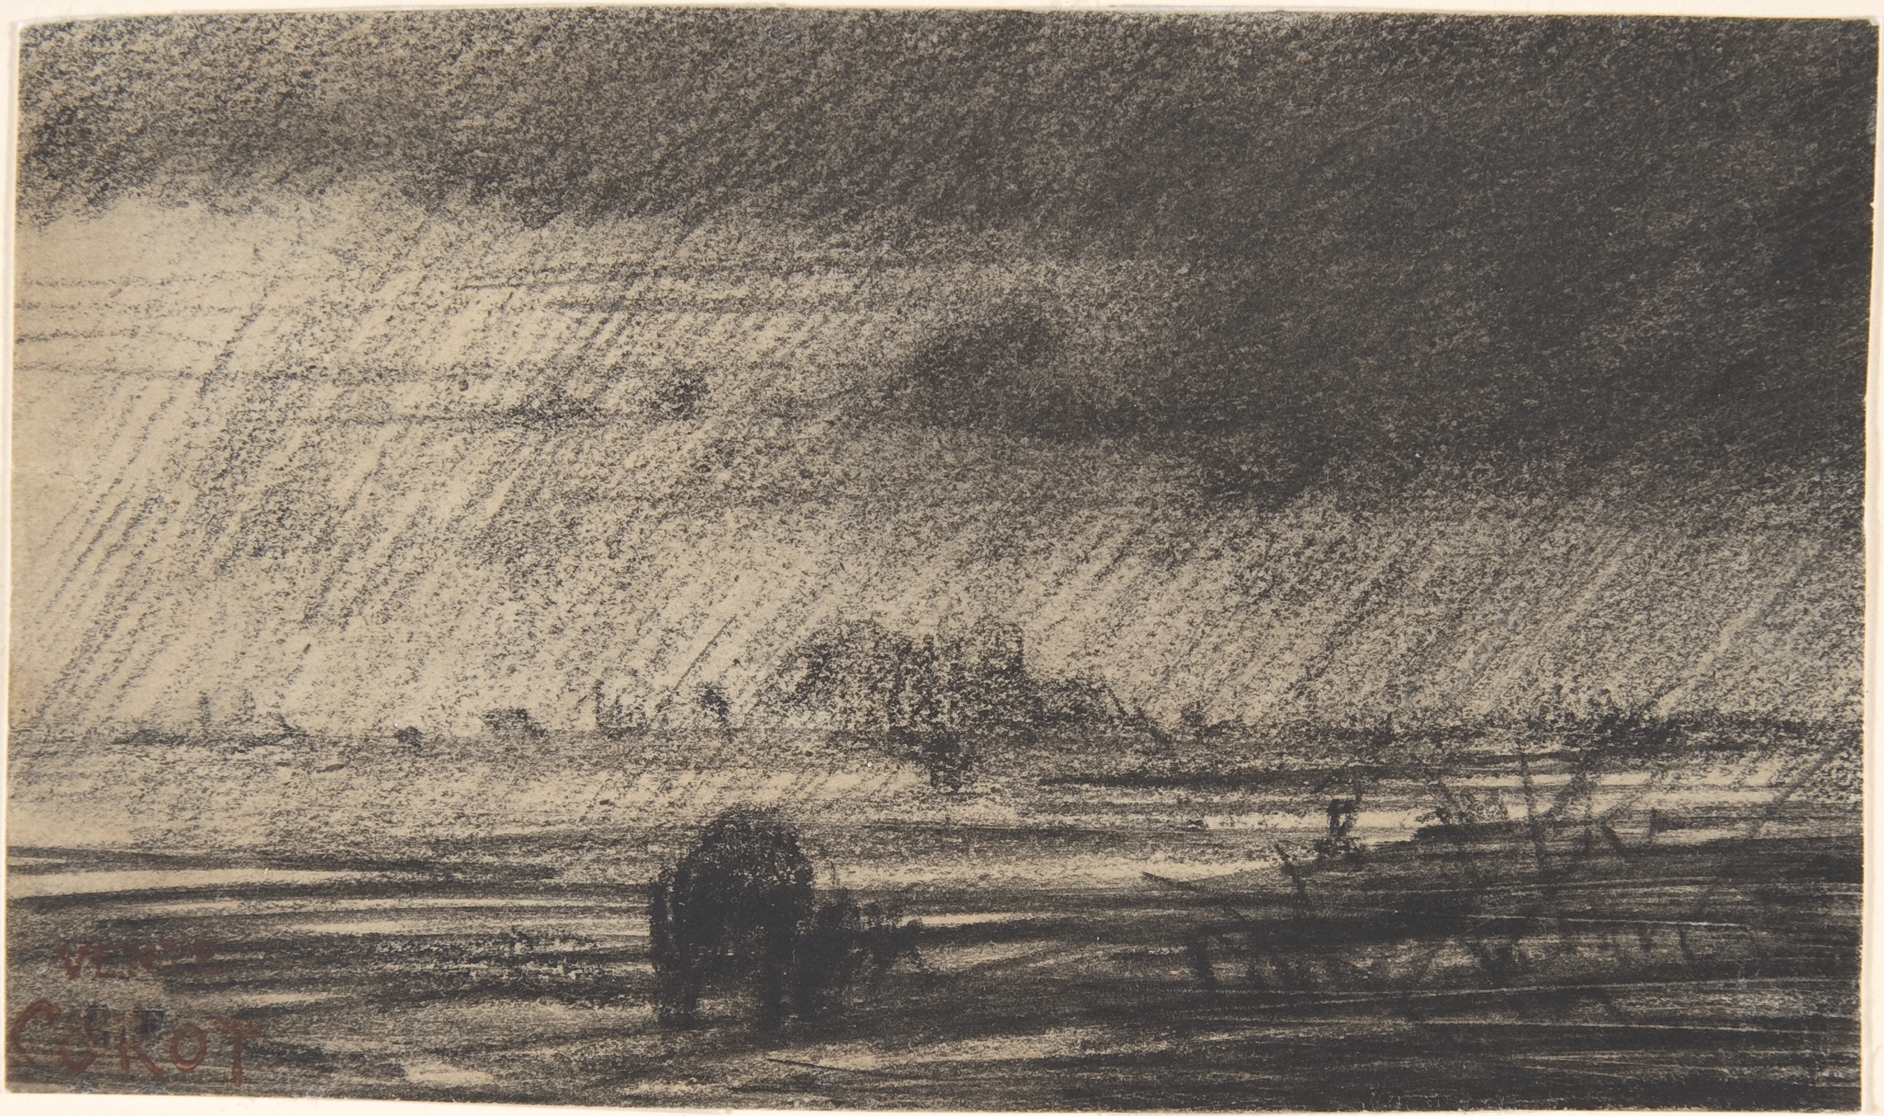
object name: drawing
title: Landscape in a Storm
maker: charles-françois daubigny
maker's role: artist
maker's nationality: french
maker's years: 1817-1878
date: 1860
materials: chalk, paper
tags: landscapes,storms